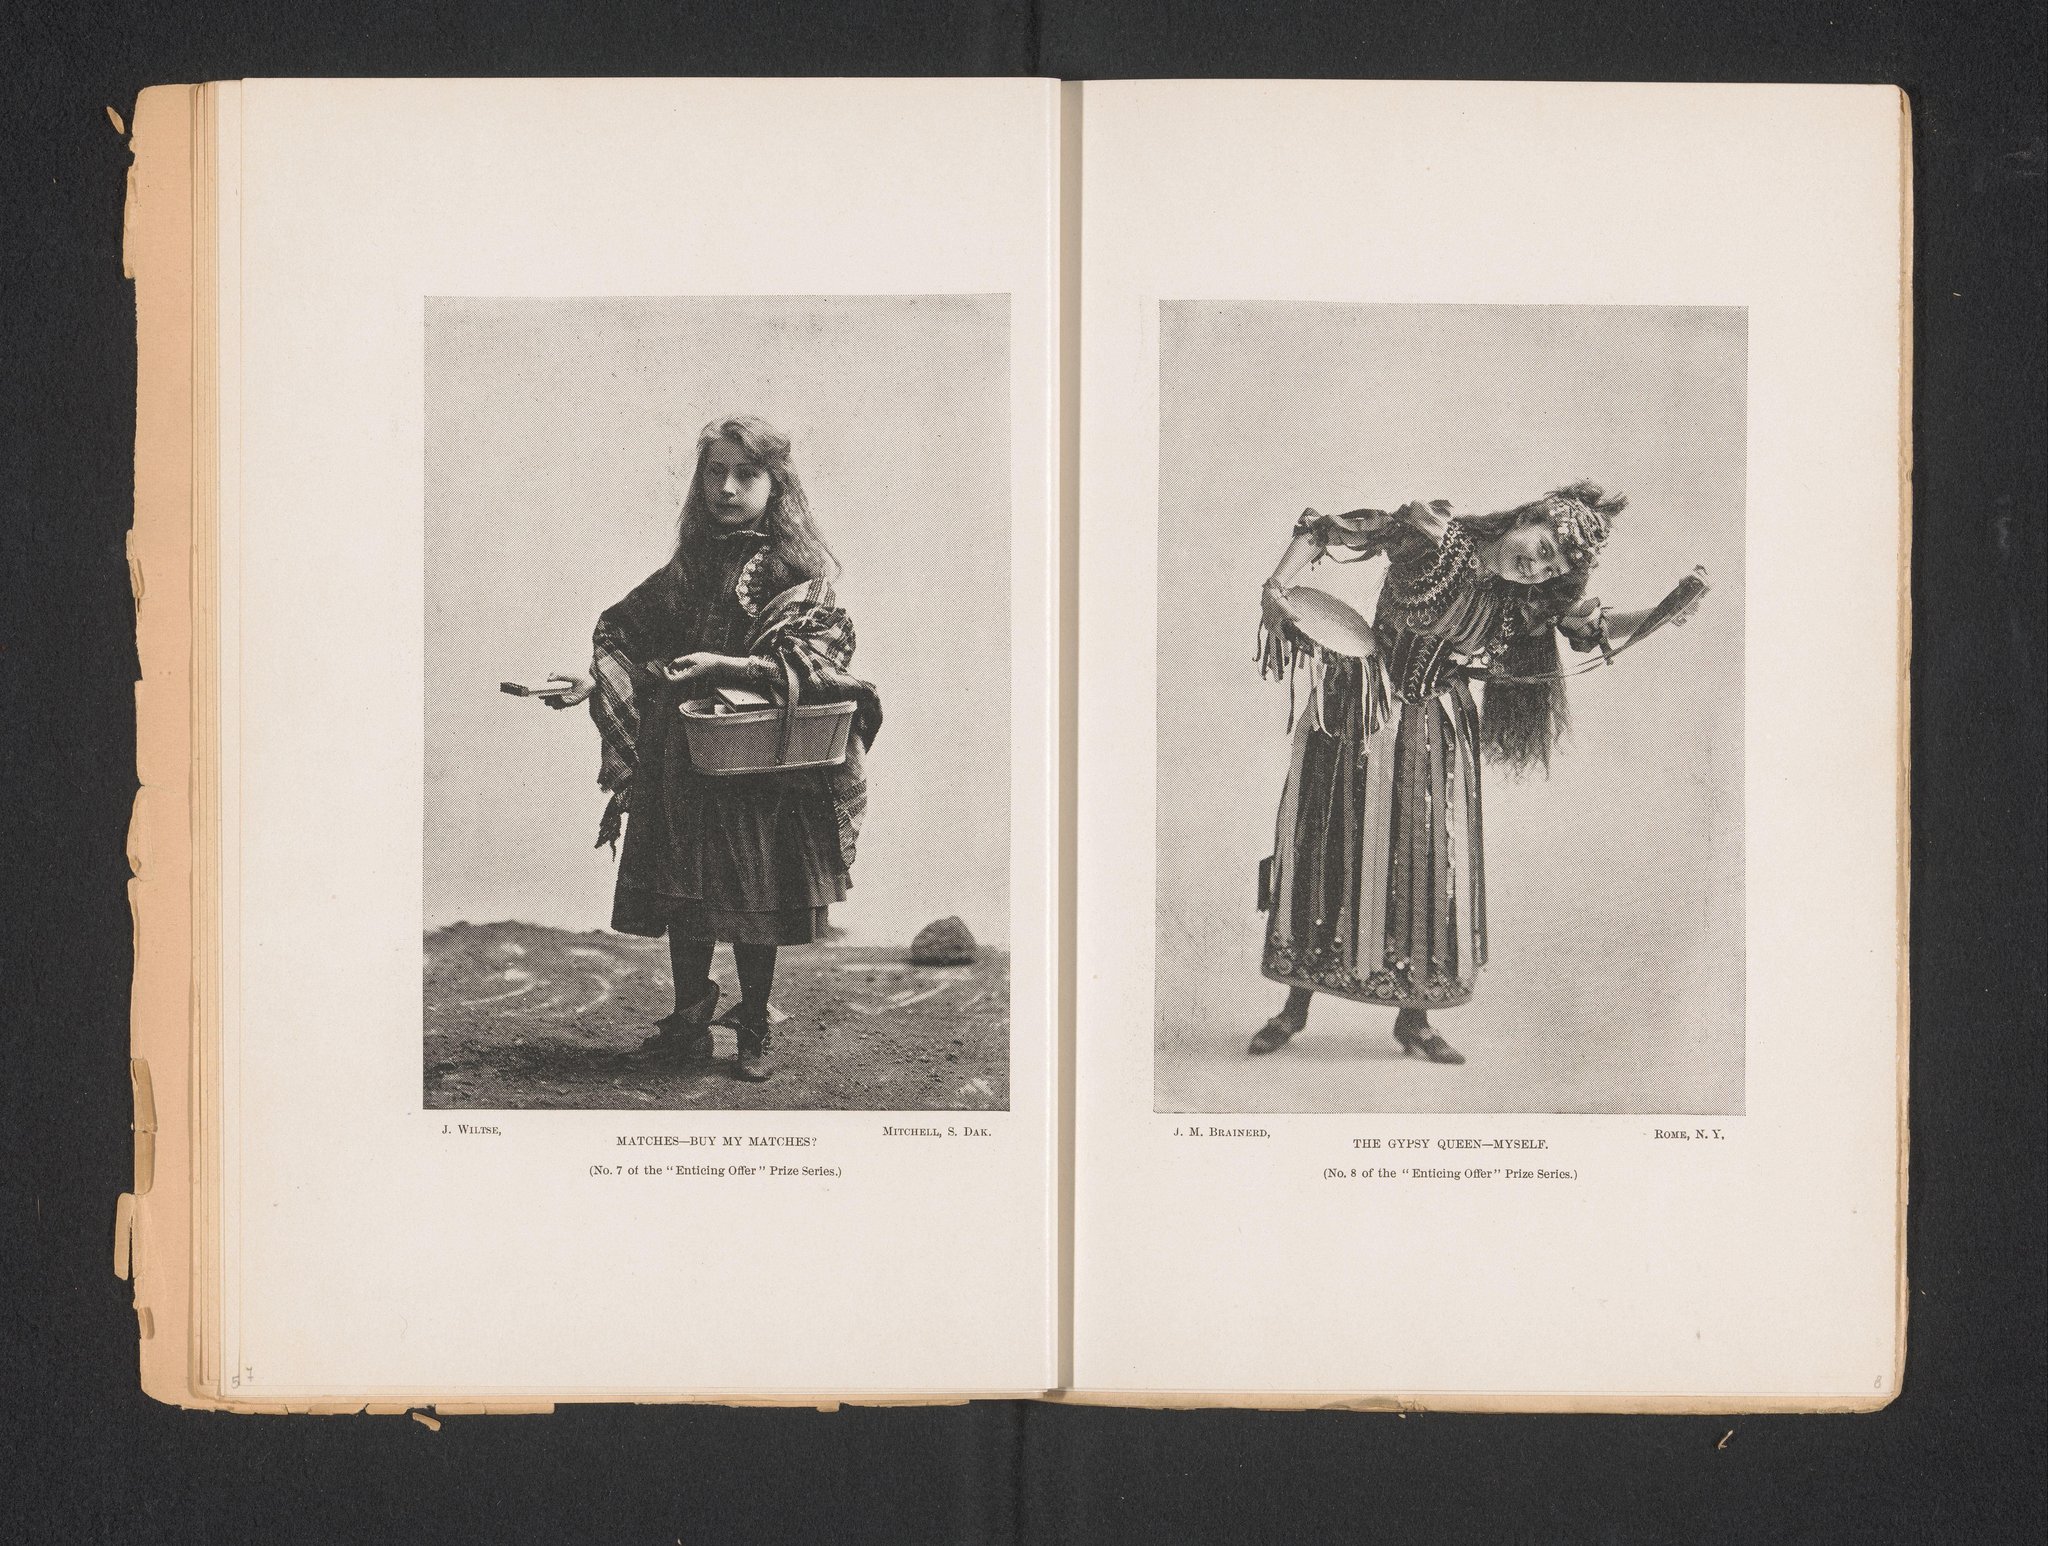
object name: photomechanical print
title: Matches - Buy My Matches?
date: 1887-1892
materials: paper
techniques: autotype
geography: south dakota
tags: historical persons not known by name - bb - woman, match, merchant, salesman - bb - women engaged in trade and commerce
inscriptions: inscription: ‘(No. 7 of the "Enticing Offer" Prize Series.)’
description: Prent zeven van vijftien prenten tussen pagina viii en pagina 545.